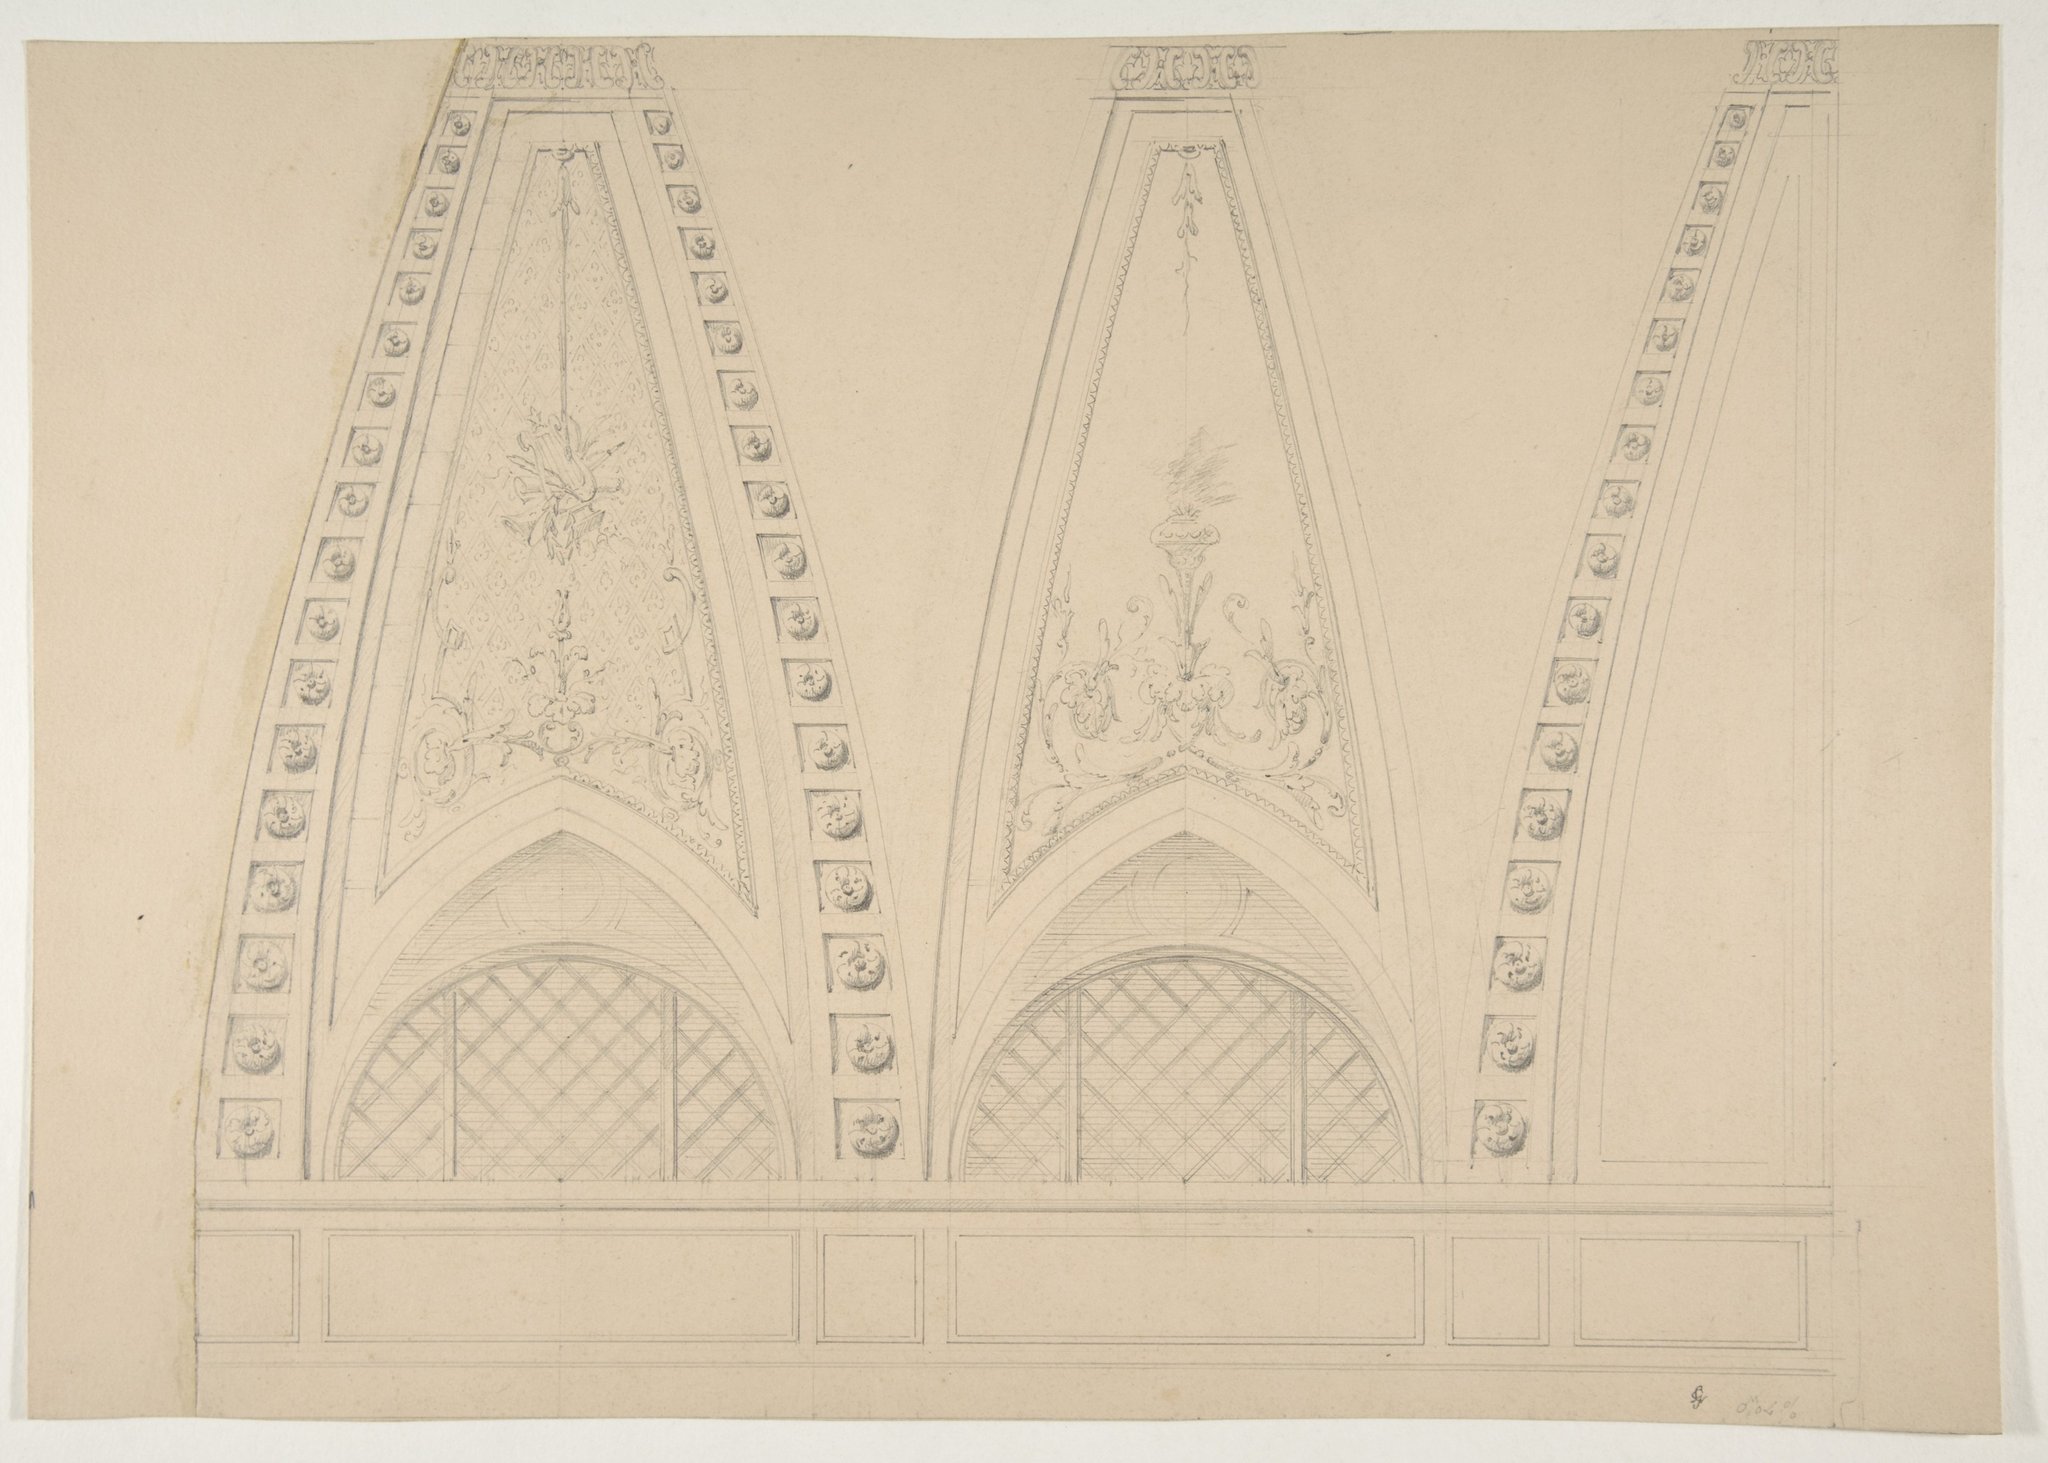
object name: drawing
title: Designs for decorated pendentives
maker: jules-edmond-charles lachaise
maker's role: artist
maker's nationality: french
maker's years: 1897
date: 1830-1897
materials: graphite, paper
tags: architecture